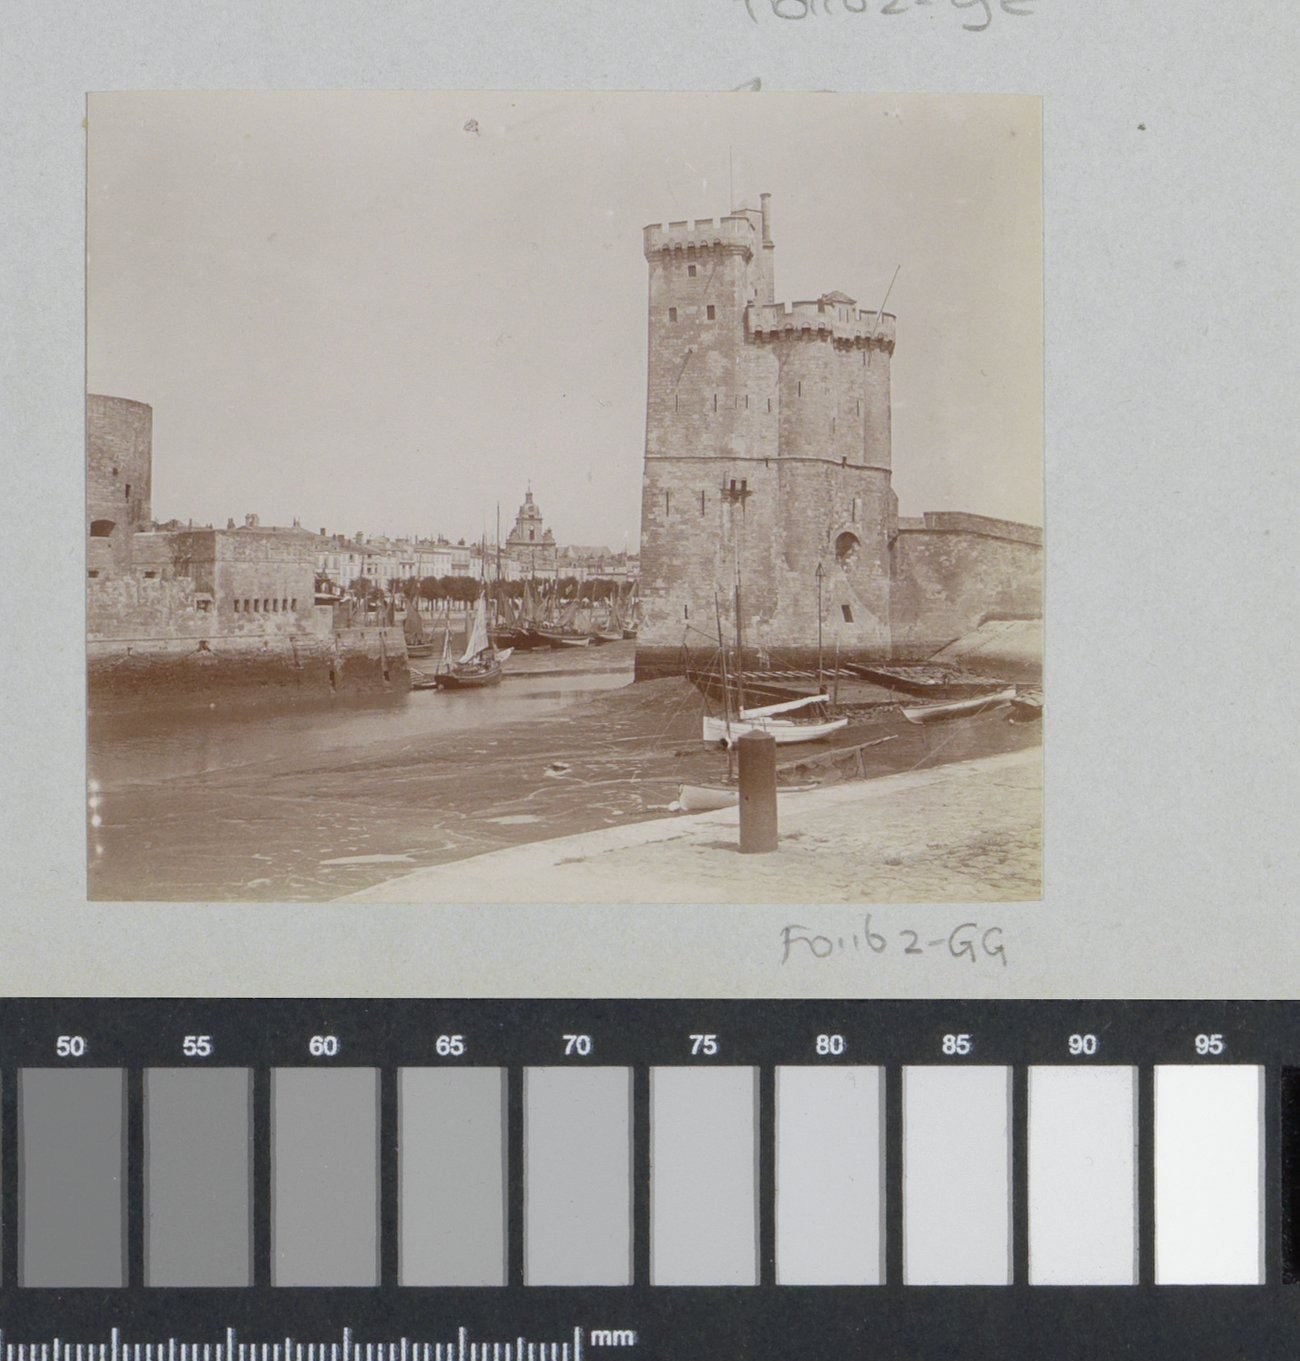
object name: photograph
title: Haveningang van La Rochelle met links de Tour de la Chaîne en rechts de Tour Saint-Nicolas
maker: Anonymous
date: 1905-1910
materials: paper, photographic support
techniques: gelatin silver print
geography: la rochelle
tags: towers ~ fortified city, harbour (+ view ~ vehicle, ship, etc.)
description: Onderdeel van Fotoalbum van een Franse amateurfotograaf met bezienswaardigheden in Frankrijk, Zwitserland en Italië.